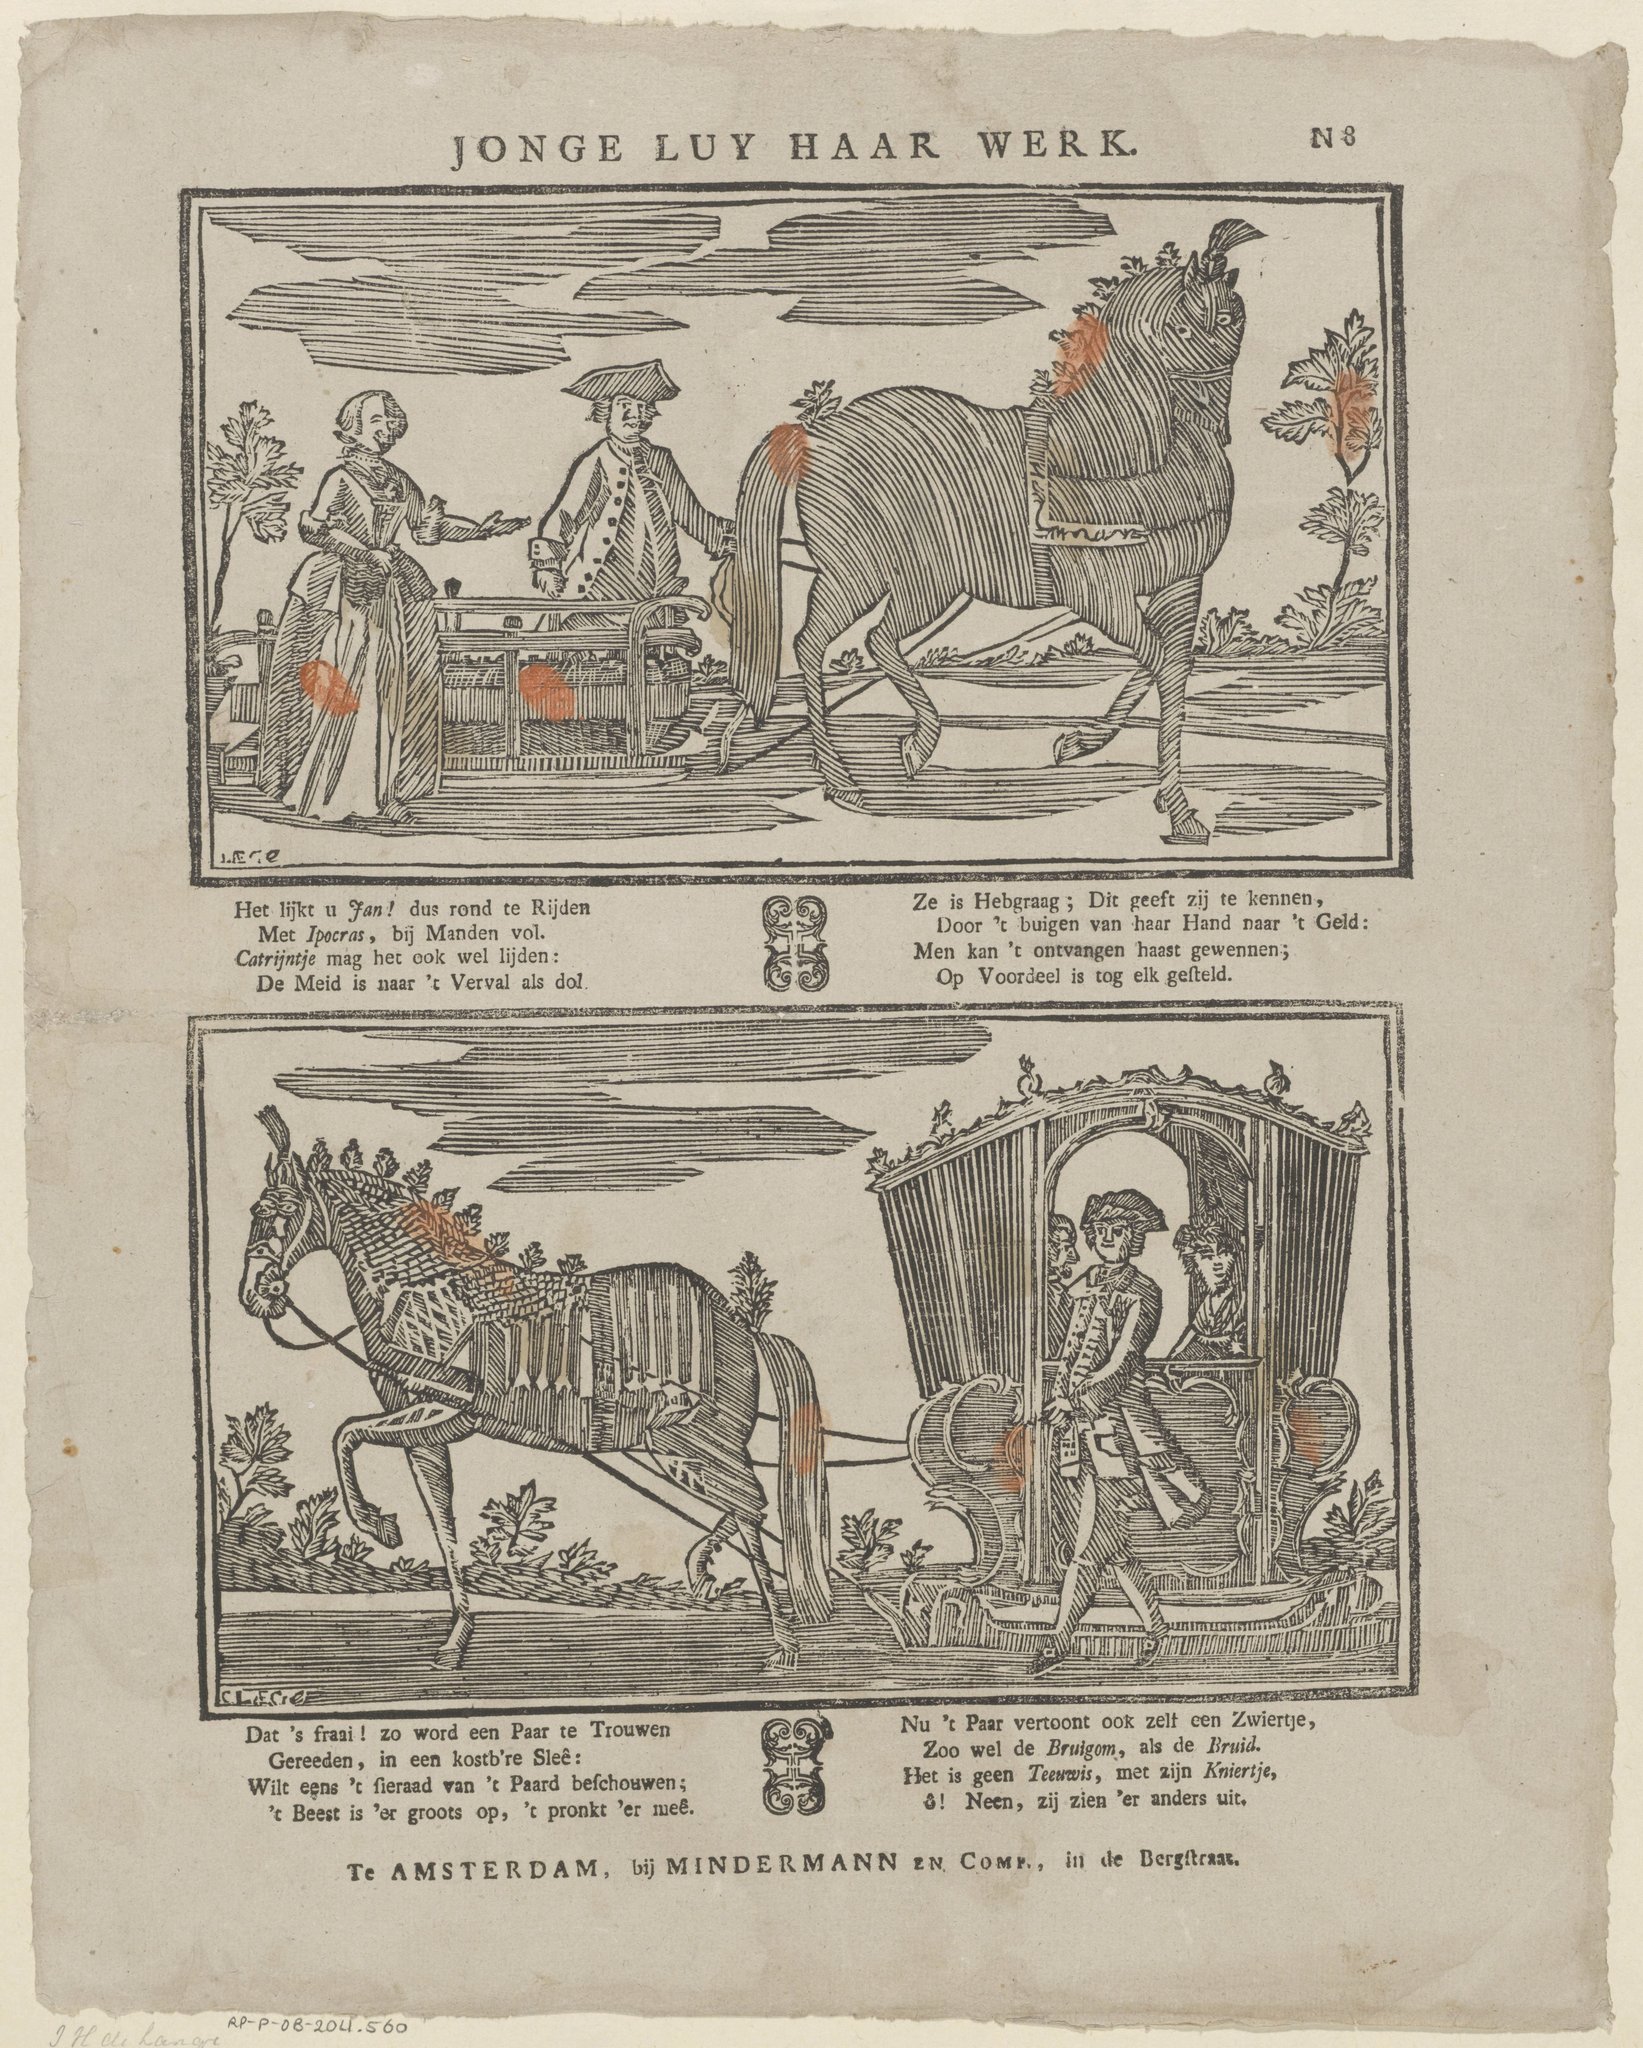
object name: popular print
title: Jonge luy haar werk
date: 1814-1848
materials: paper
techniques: colour, letterpress printing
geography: deventer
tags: horse-sleigh, sleigh, sledge (non-sport)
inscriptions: collector's mark: Lugt 2760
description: Blad met 2 voorstellingen. Boven een bruidspaar lopend naast een open slee, die wordt voortgetrokken door een paard. Onder een bruidspaar zittend in een gesloten slee, die wordt voortgetrokken door een paard. Onder elke afbeelding een achtregelig vers in twee kolommen. Genummerd rechtsboven: N 8.